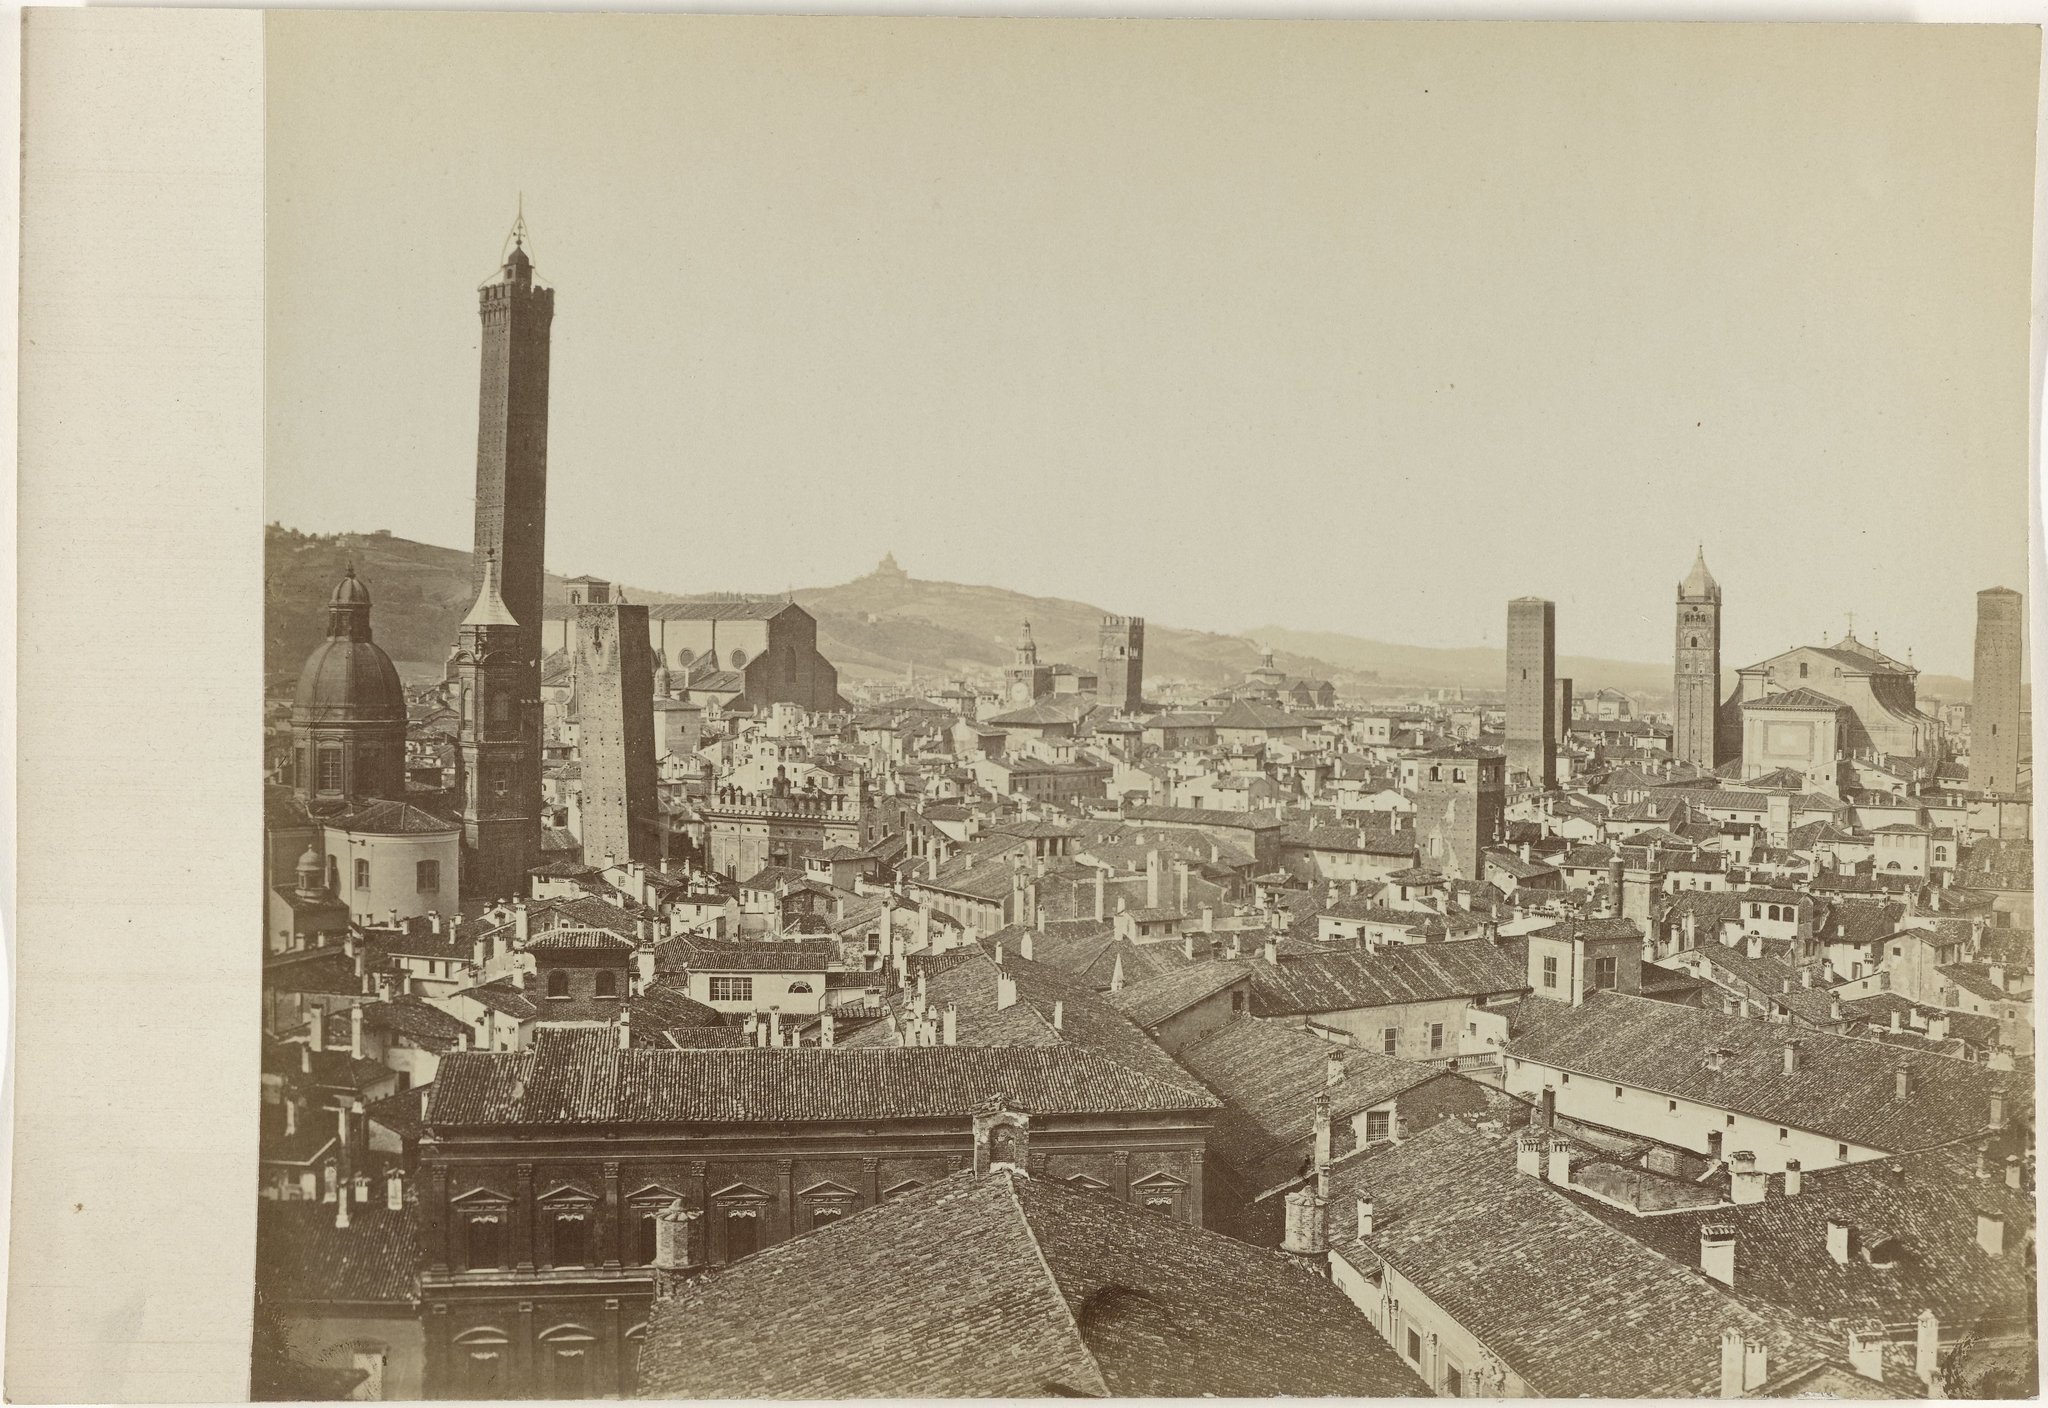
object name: photograph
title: Gezicht in vogelvlucht op Bologna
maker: r. peli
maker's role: fotograaf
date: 1870-1890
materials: cardboard, paper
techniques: albumen print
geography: bologna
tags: prospect of city, town panorama, silhouette of city